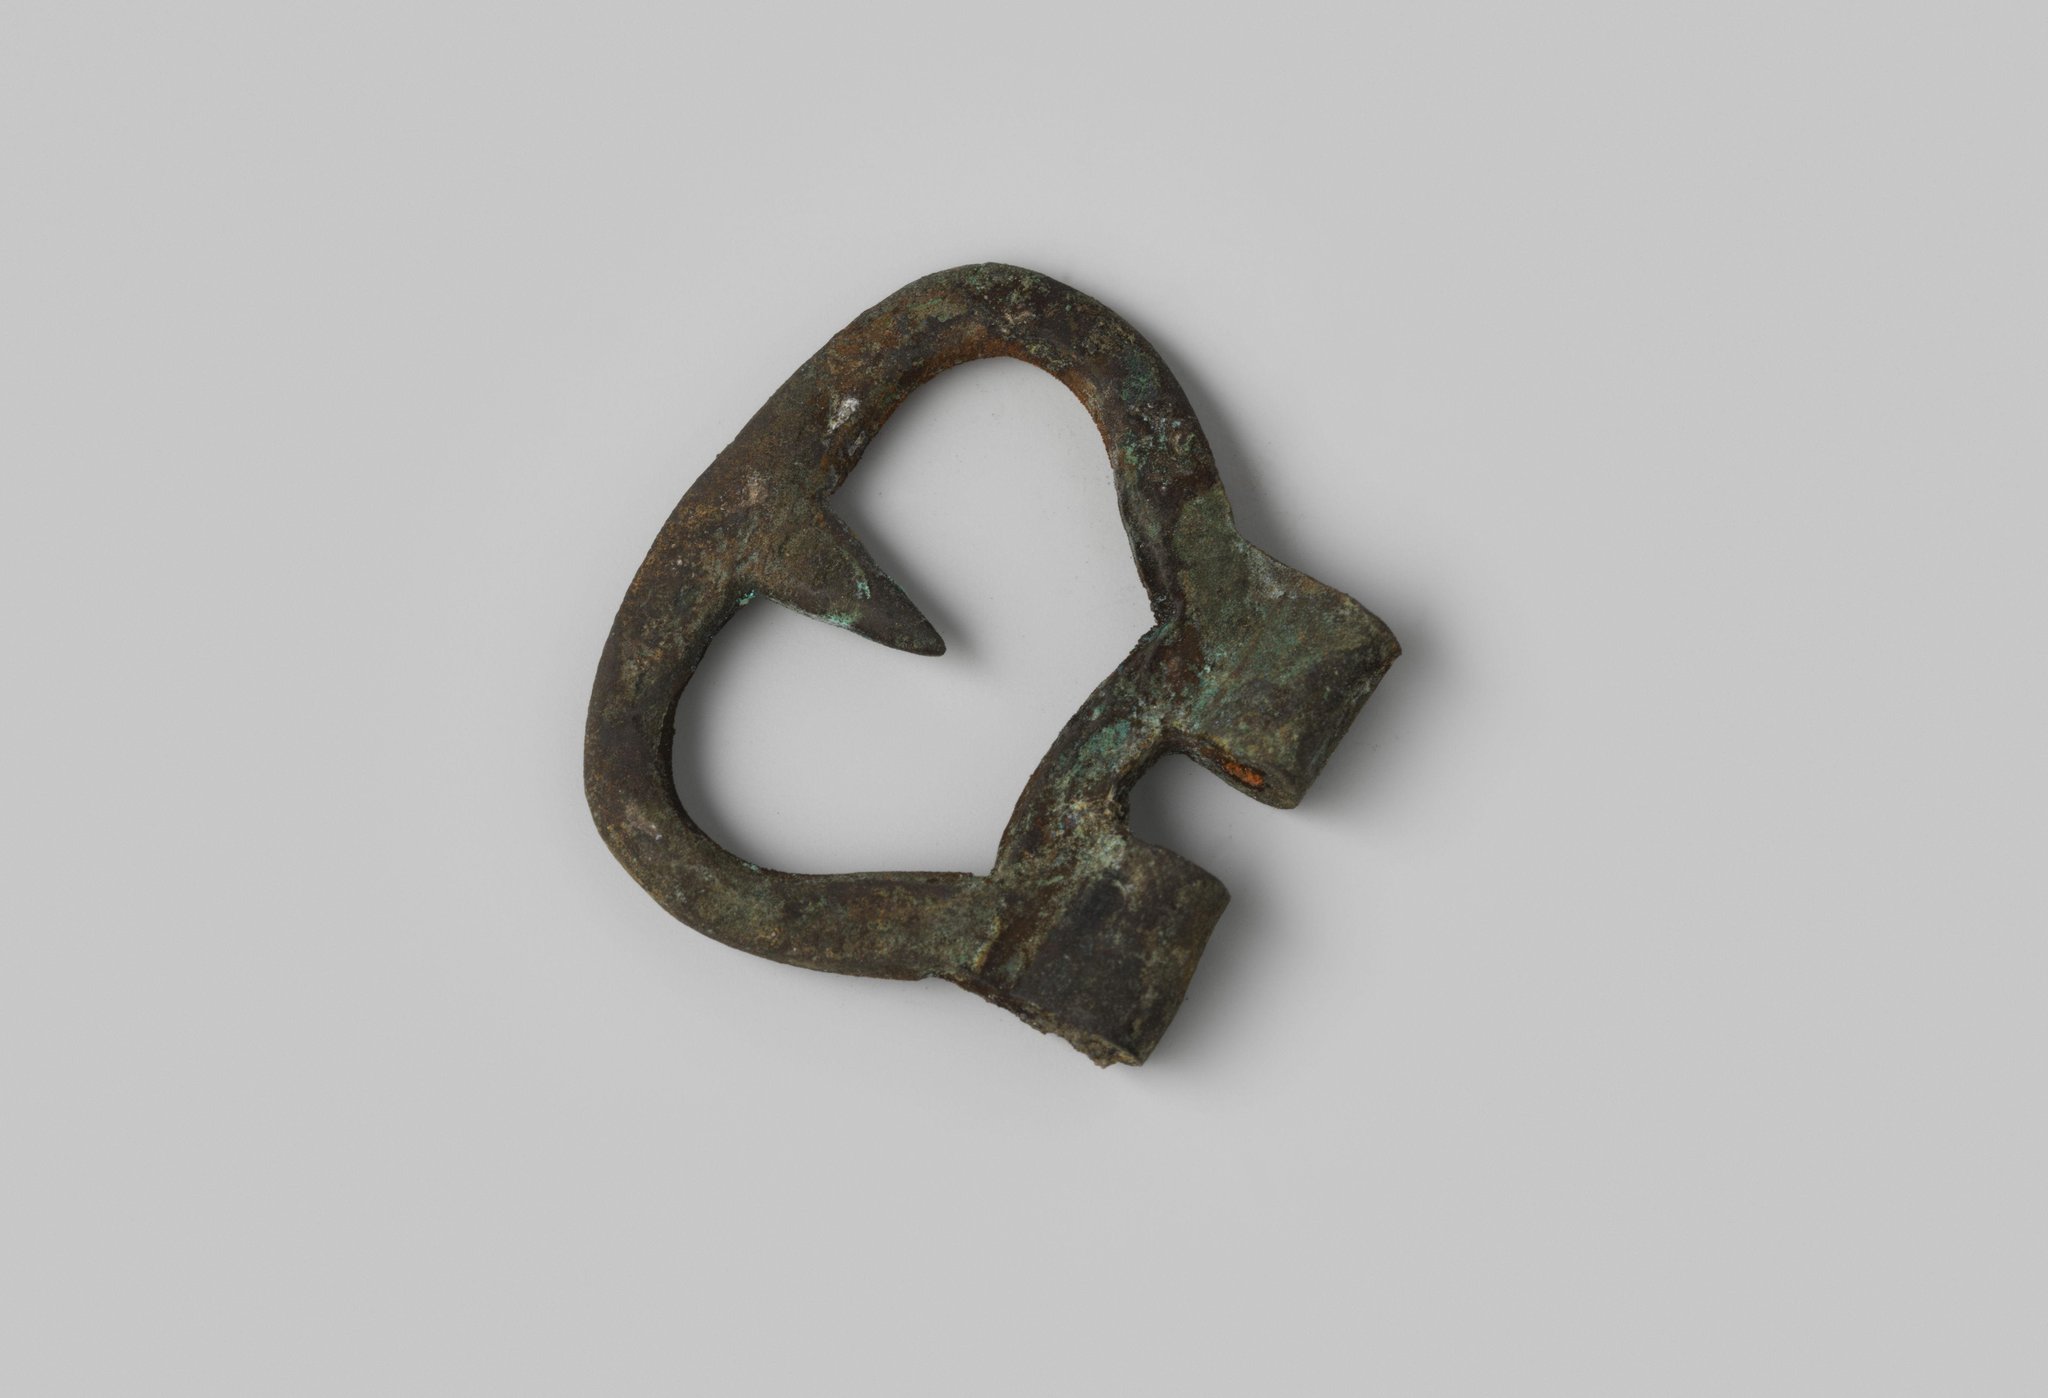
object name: buckle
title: Gesp uit het wrak van de Oost-Indiëvaarder Hollandia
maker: Anonymous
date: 1700-1743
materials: copper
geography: netherlands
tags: verenigde oostindische compagnie, hollandia (schip), annet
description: Buckle, chape buckle, chape; single-pronged loop, oval.